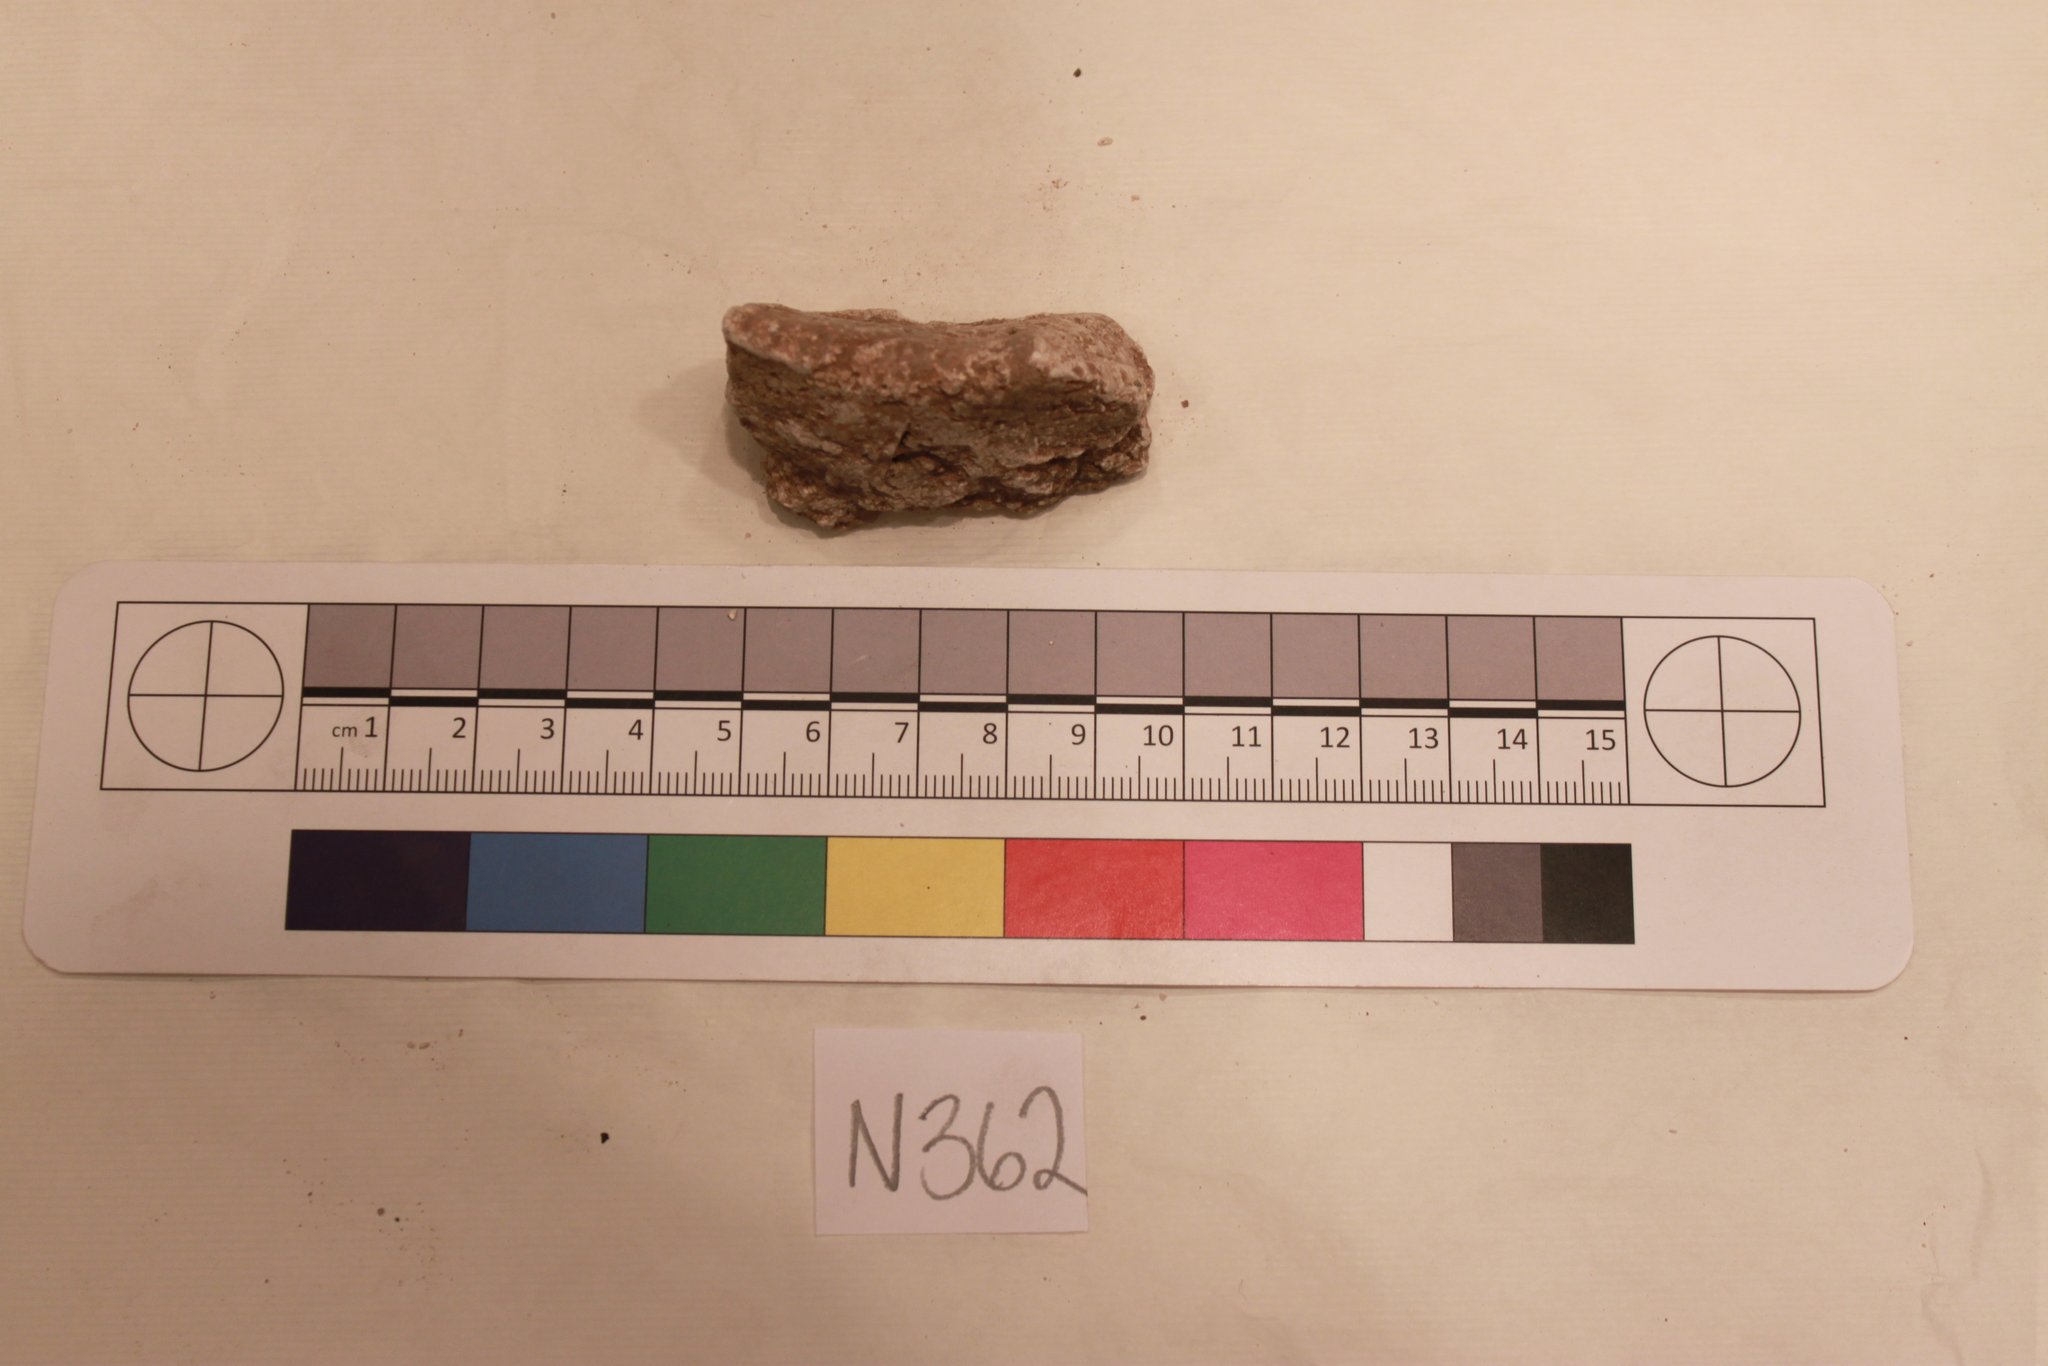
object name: fragment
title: Stucco Fragment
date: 701-1200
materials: plaster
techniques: carving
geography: iran